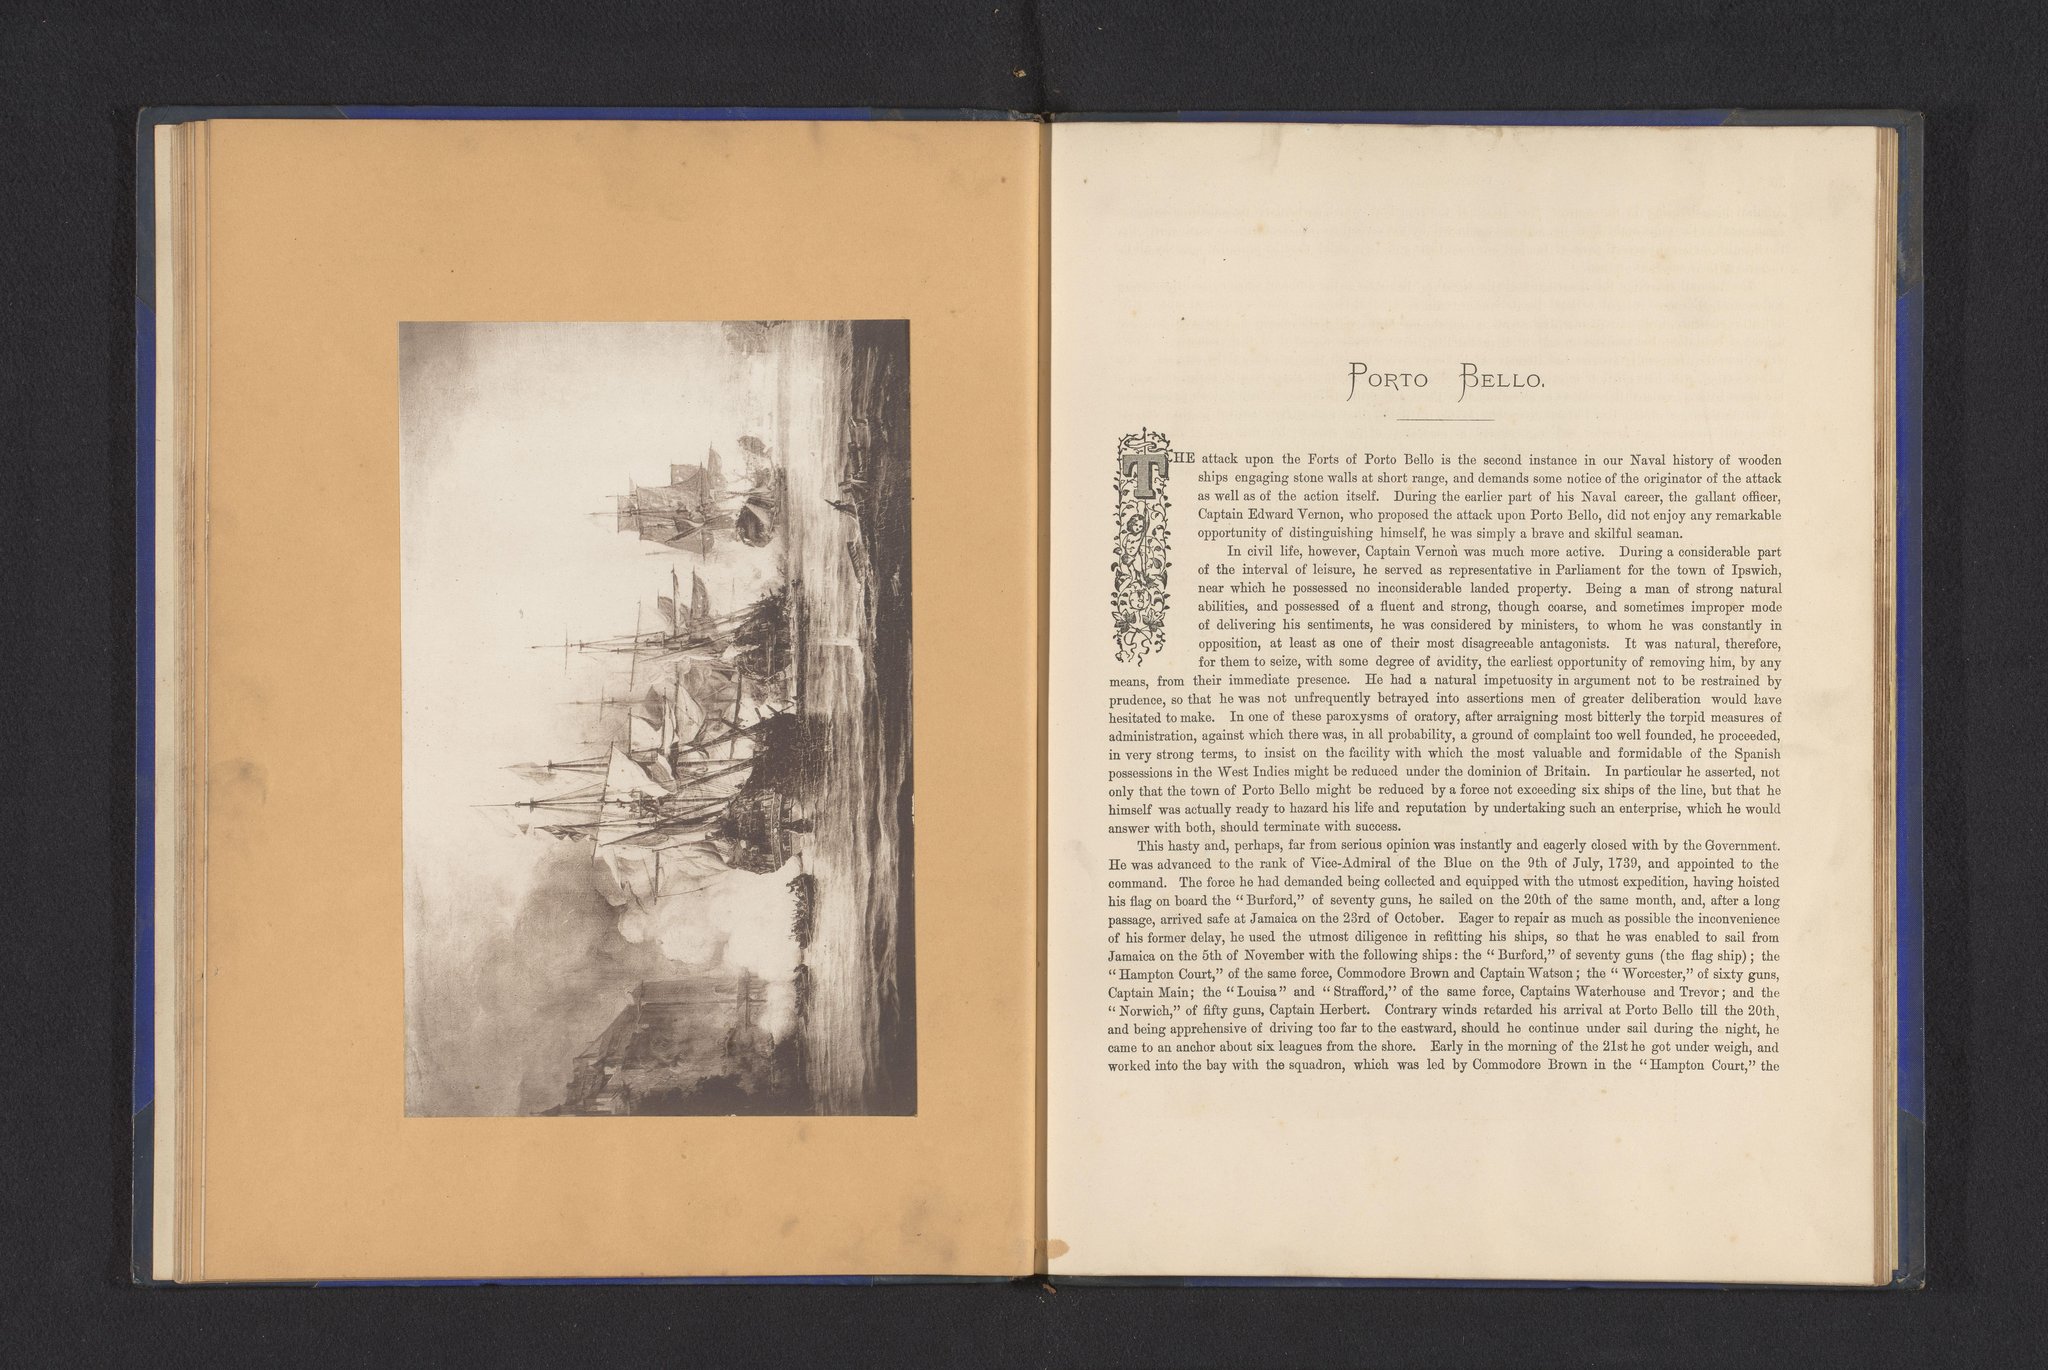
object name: photomechanical print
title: Reproductie van een schilderij van de slag bij Portobello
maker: Anonymous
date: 1876-1881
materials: paper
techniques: photograph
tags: battle (+ naval force)